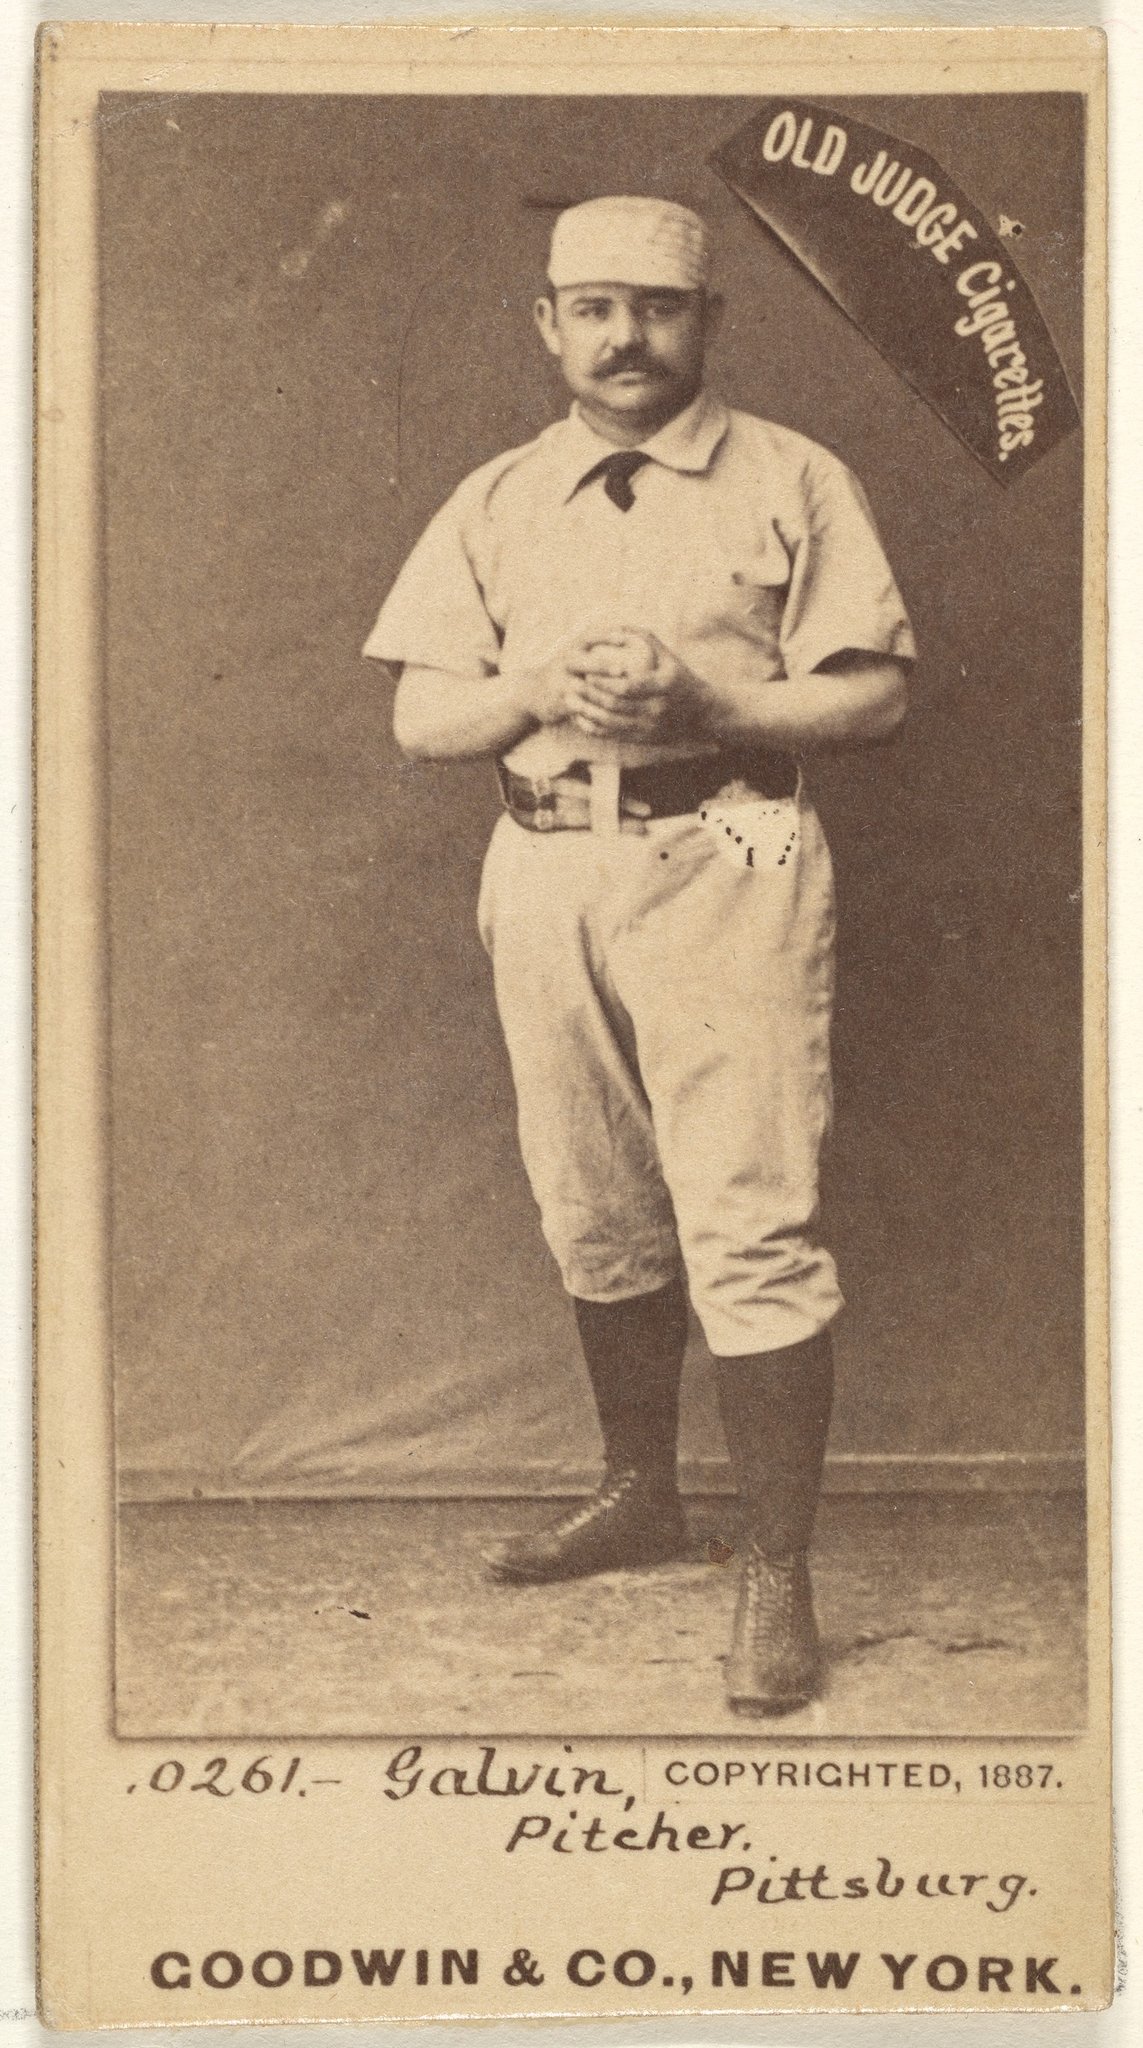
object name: baseball card, photograph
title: James Francis "Pud" Galvin, Pitcher, Pittsburgh, from the Old Judge series (N172) for Old Judge Cigarettes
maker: goodwin & company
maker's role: publisher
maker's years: 1850-1950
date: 1887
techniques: albumen silver print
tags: men,portraits,baseball,athletes